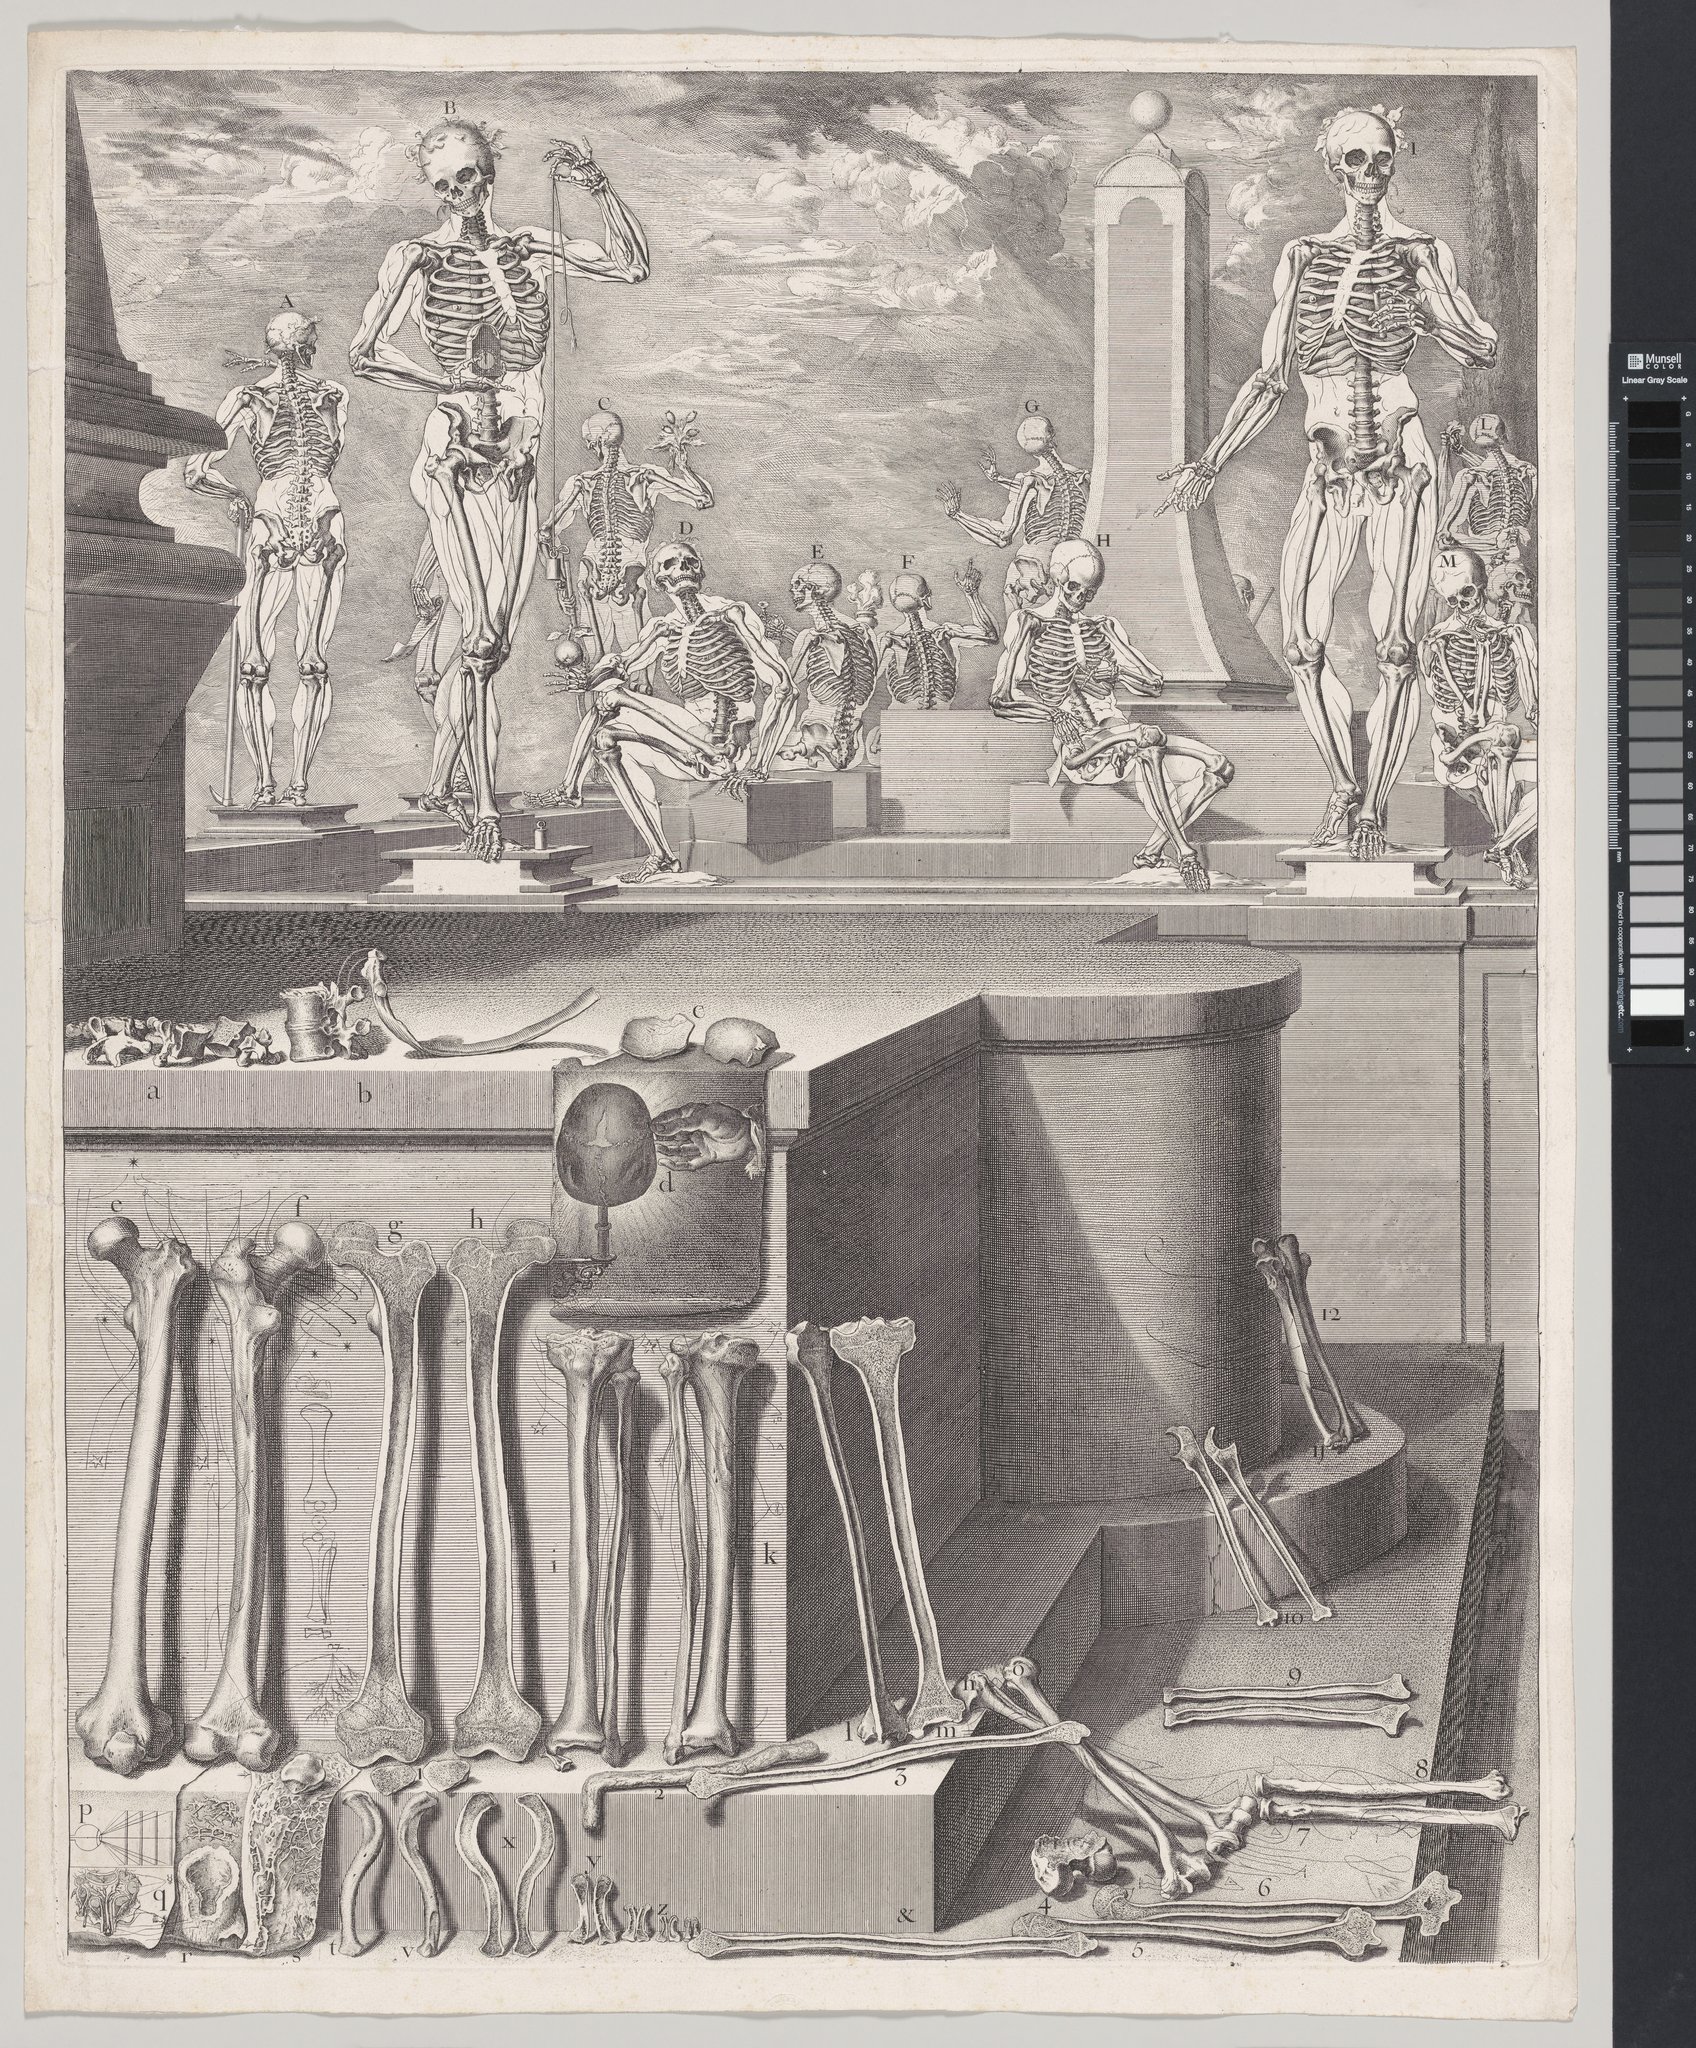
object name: print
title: Plate for the ‘Atlas Anatomico’ (unpublished)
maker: crisóstomo alejandrino josé martínez y sorli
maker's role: artist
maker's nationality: spanish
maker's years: 1638-1694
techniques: etching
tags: skeletons